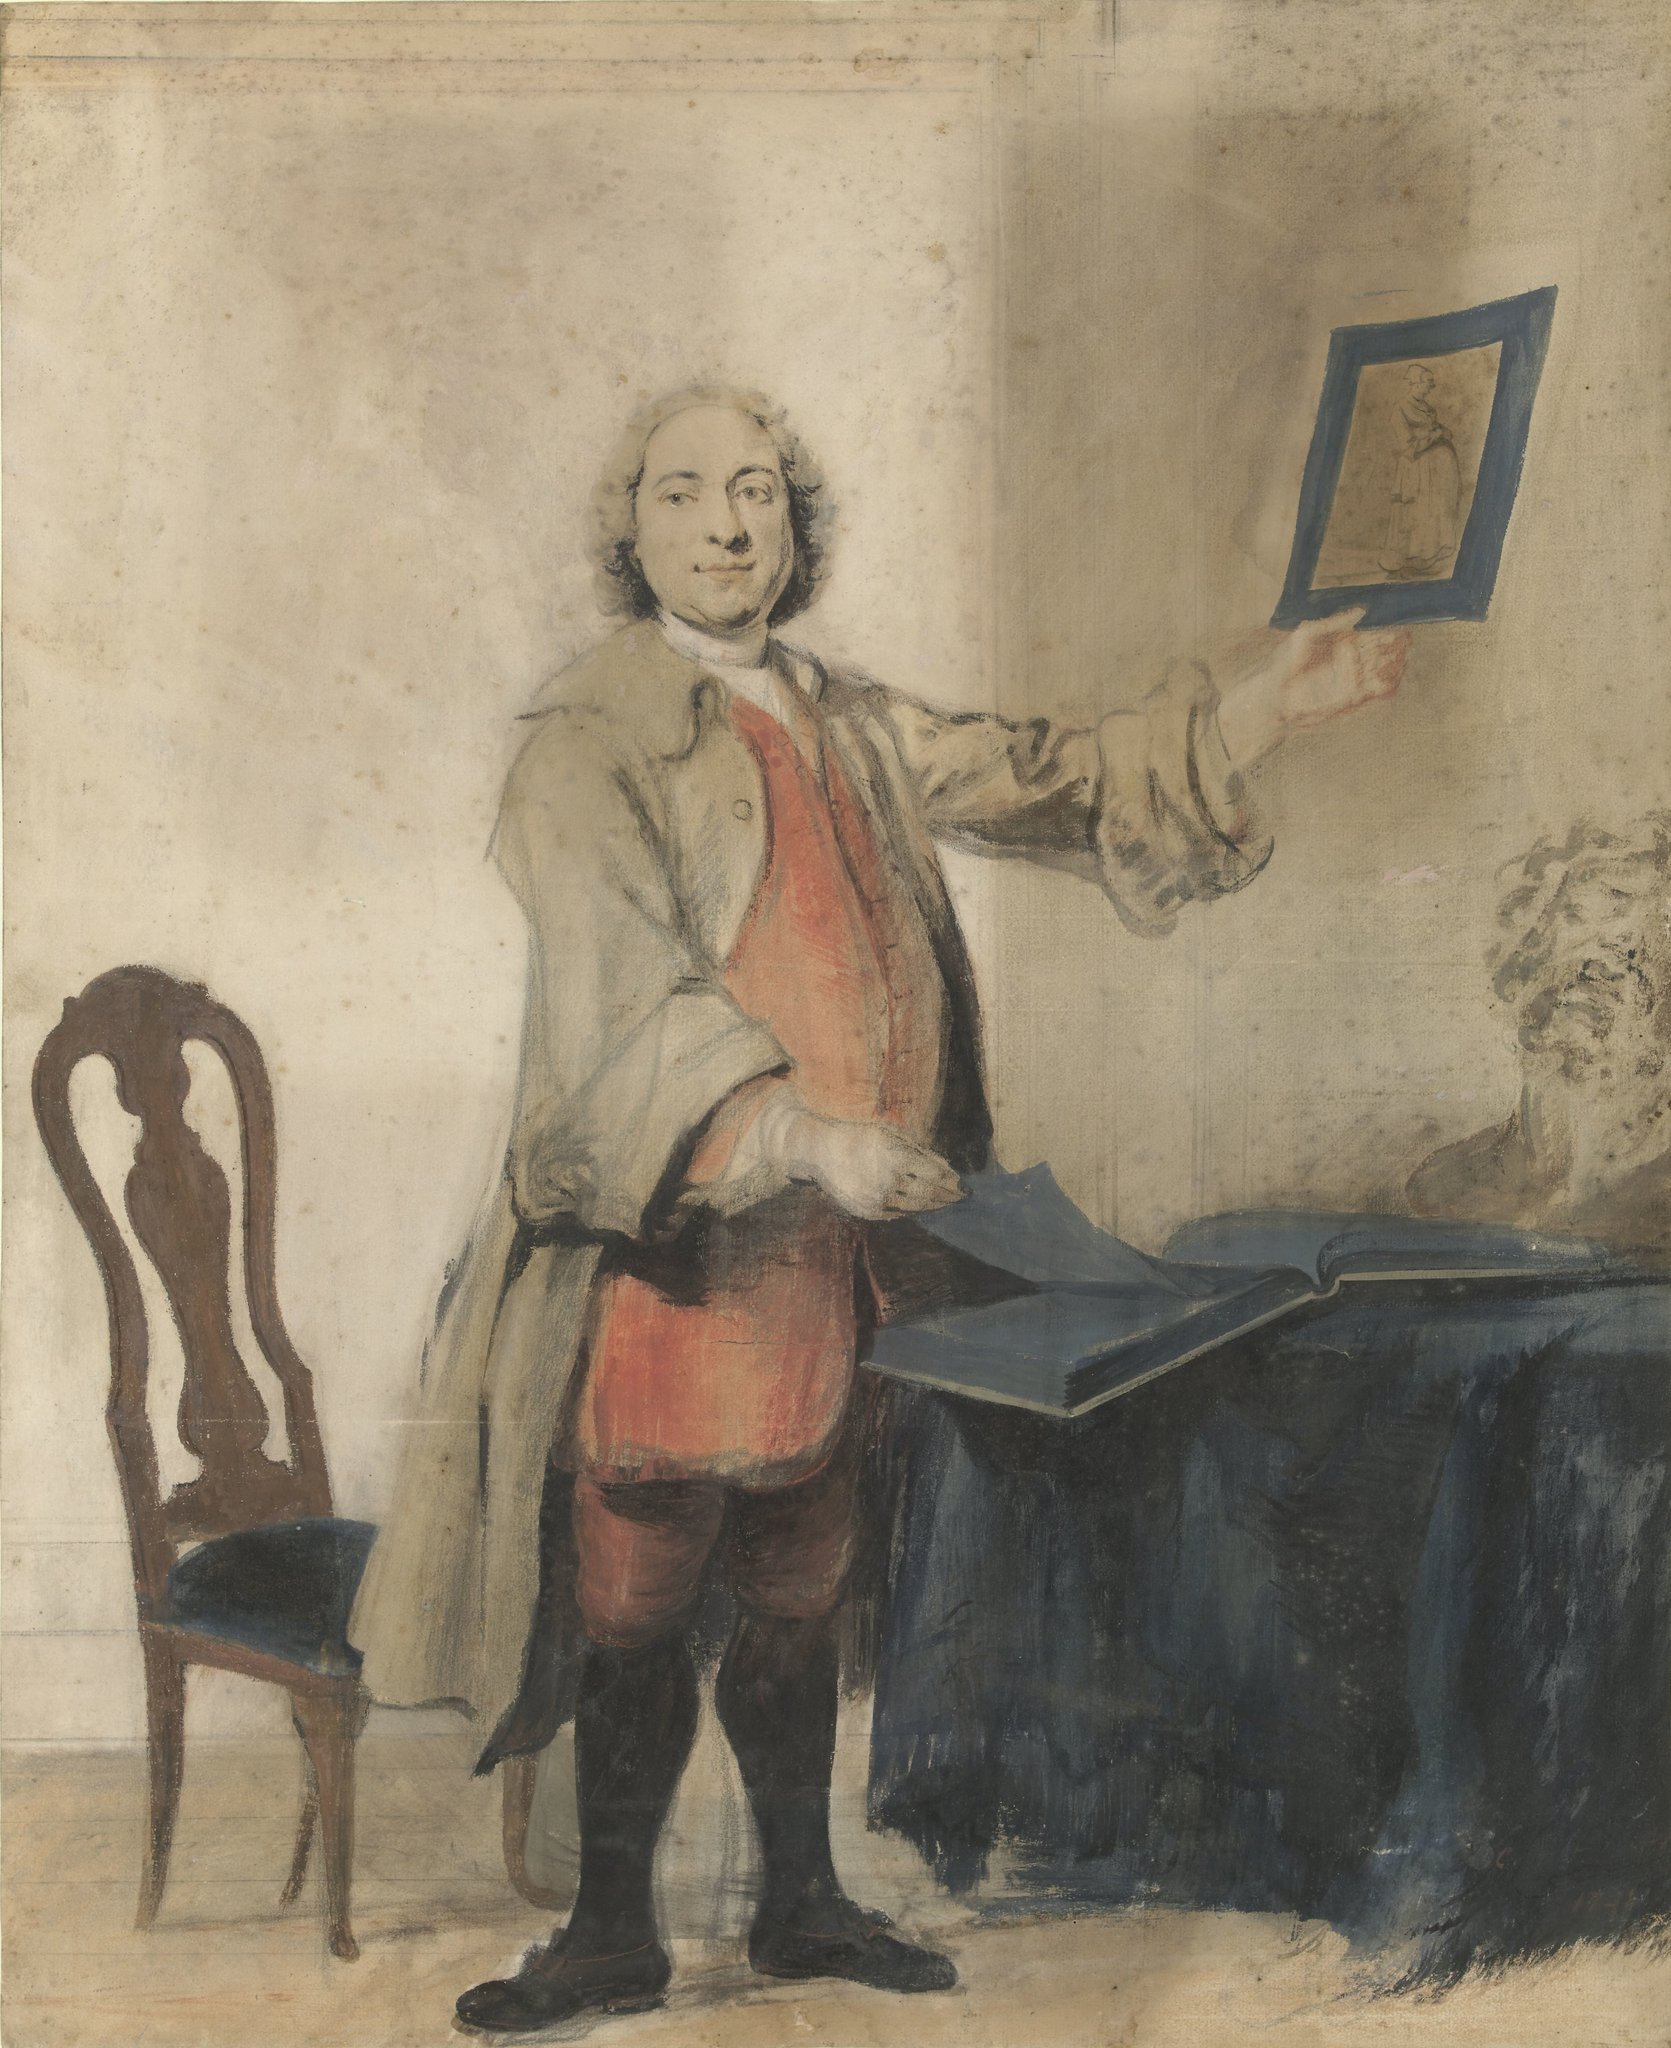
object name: drawing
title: Portret van Cornelis Bouman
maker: cornelis troost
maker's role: draughtsman, painter, print maker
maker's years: 1696-1750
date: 1741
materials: chalk, paint, paper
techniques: brush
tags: portrait, self-portrait of painter, portrait, self-portrait of artist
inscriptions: date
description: De figuur op de tekening in de hand van de man komt overeen met de figuur van Beslikte Swaantje op een schilderij van Cornelis Troost.